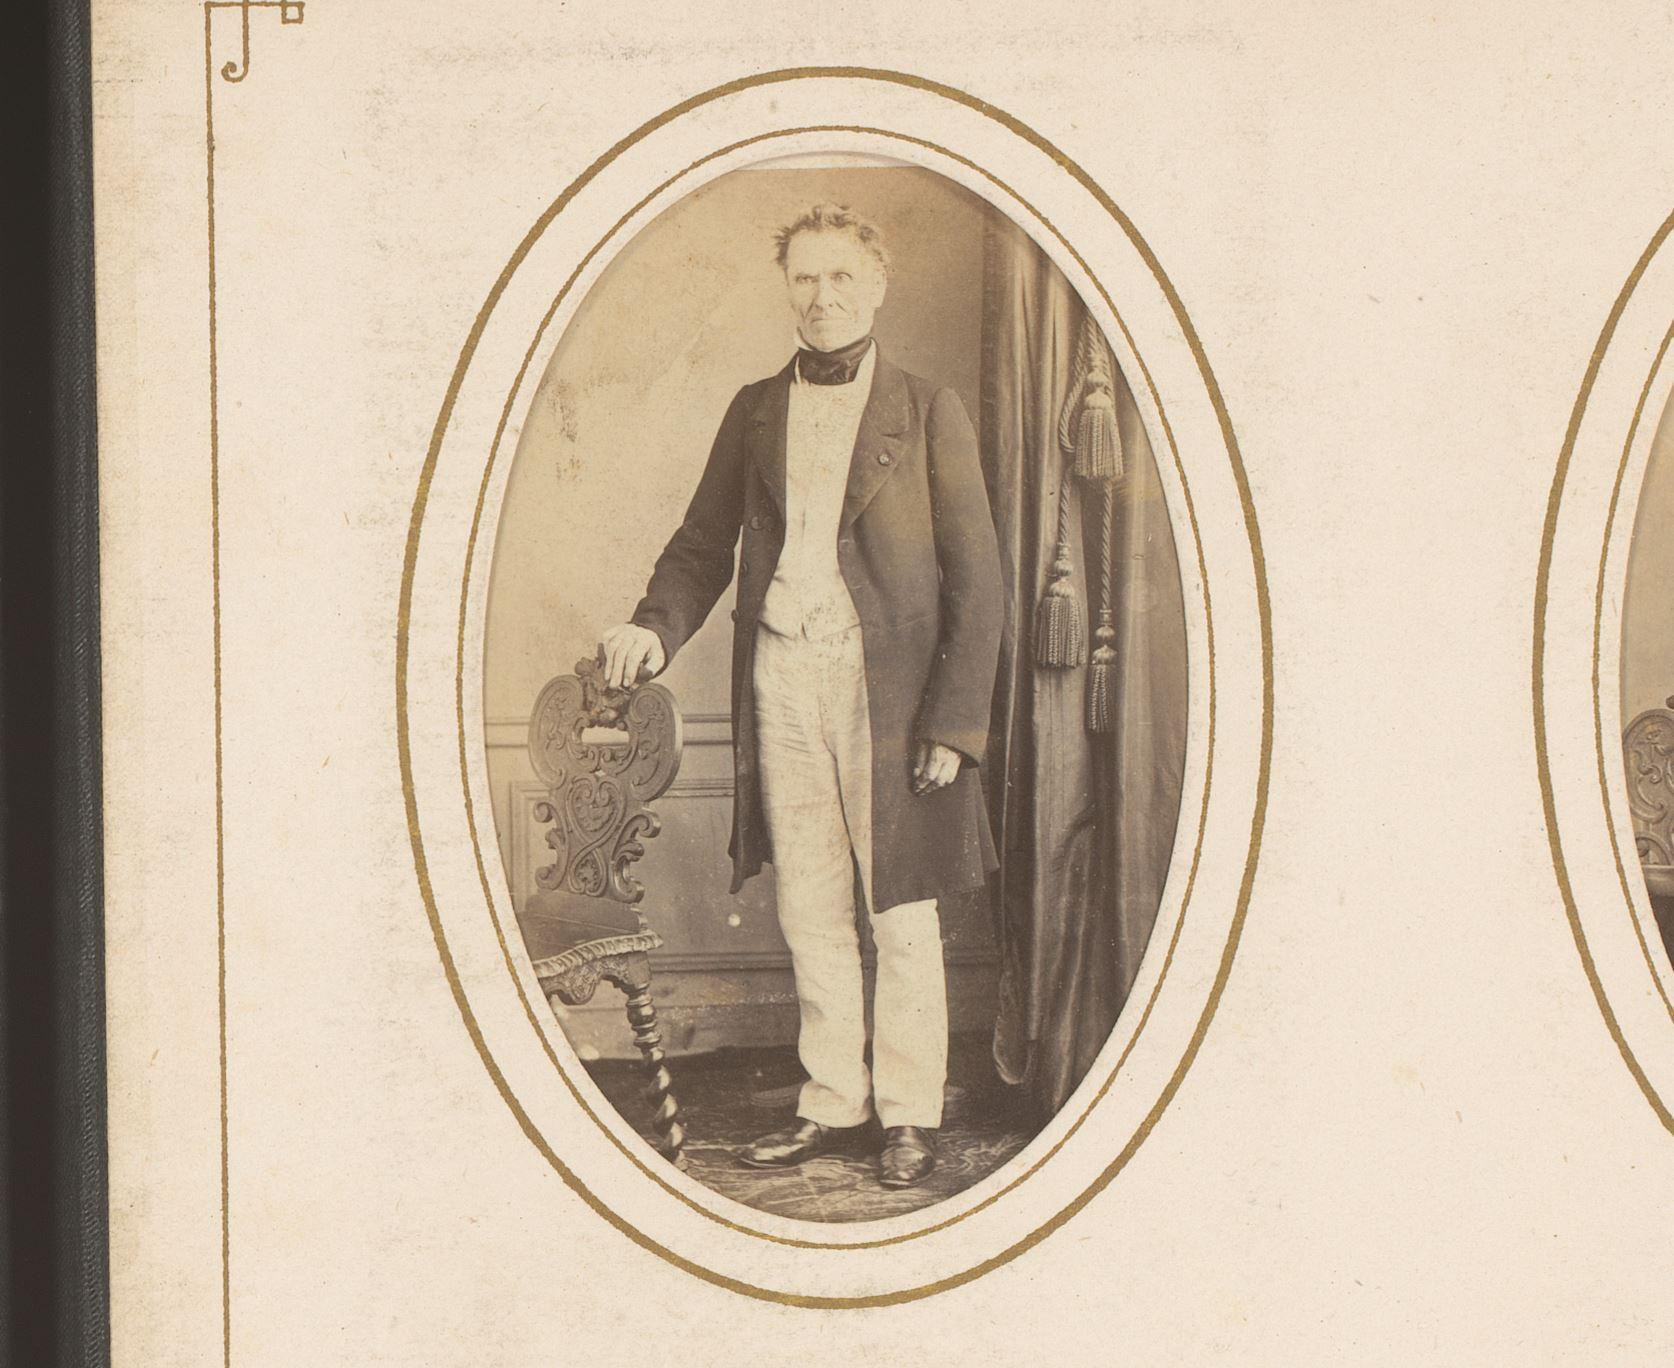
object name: carte de visite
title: Portret van een man, staand bij en stoel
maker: pierre eugène thiebault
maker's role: fotograaf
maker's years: 1825-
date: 1852-1870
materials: cardboard, photographic support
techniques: albumen print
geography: paris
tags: standing figure, historical persons, chair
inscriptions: inscription: ‘THIÉBAULT,/ Bt. Bne. Nouvelle, 31.’